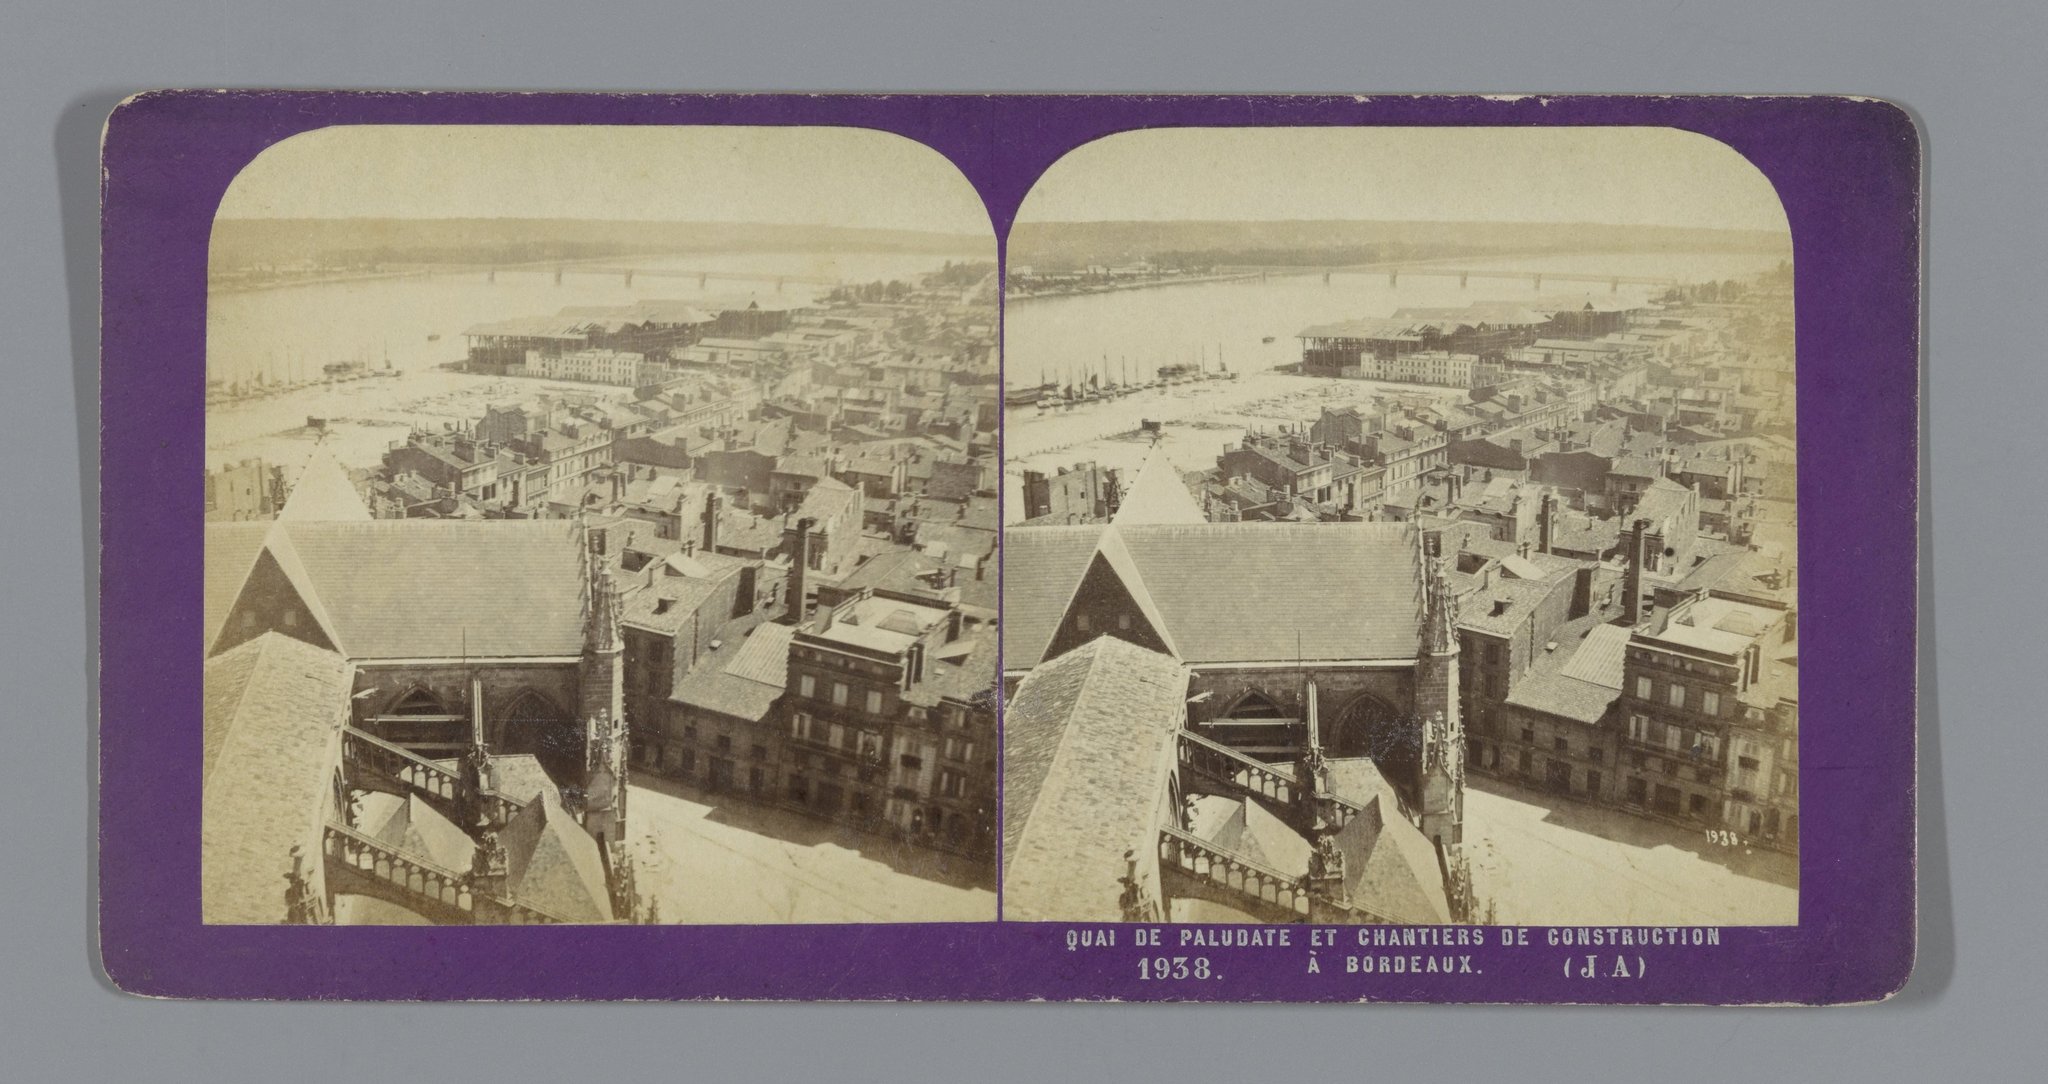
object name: stereograph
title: Quai de paludate et chantiers de construction, à Bordeaux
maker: jean andrieu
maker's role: fotograaf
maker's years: 1816-1872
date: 1862-1876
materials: cardboard, photographic support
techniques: albumen print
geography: bordeaux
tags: quay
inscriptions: number: ‘1938.’